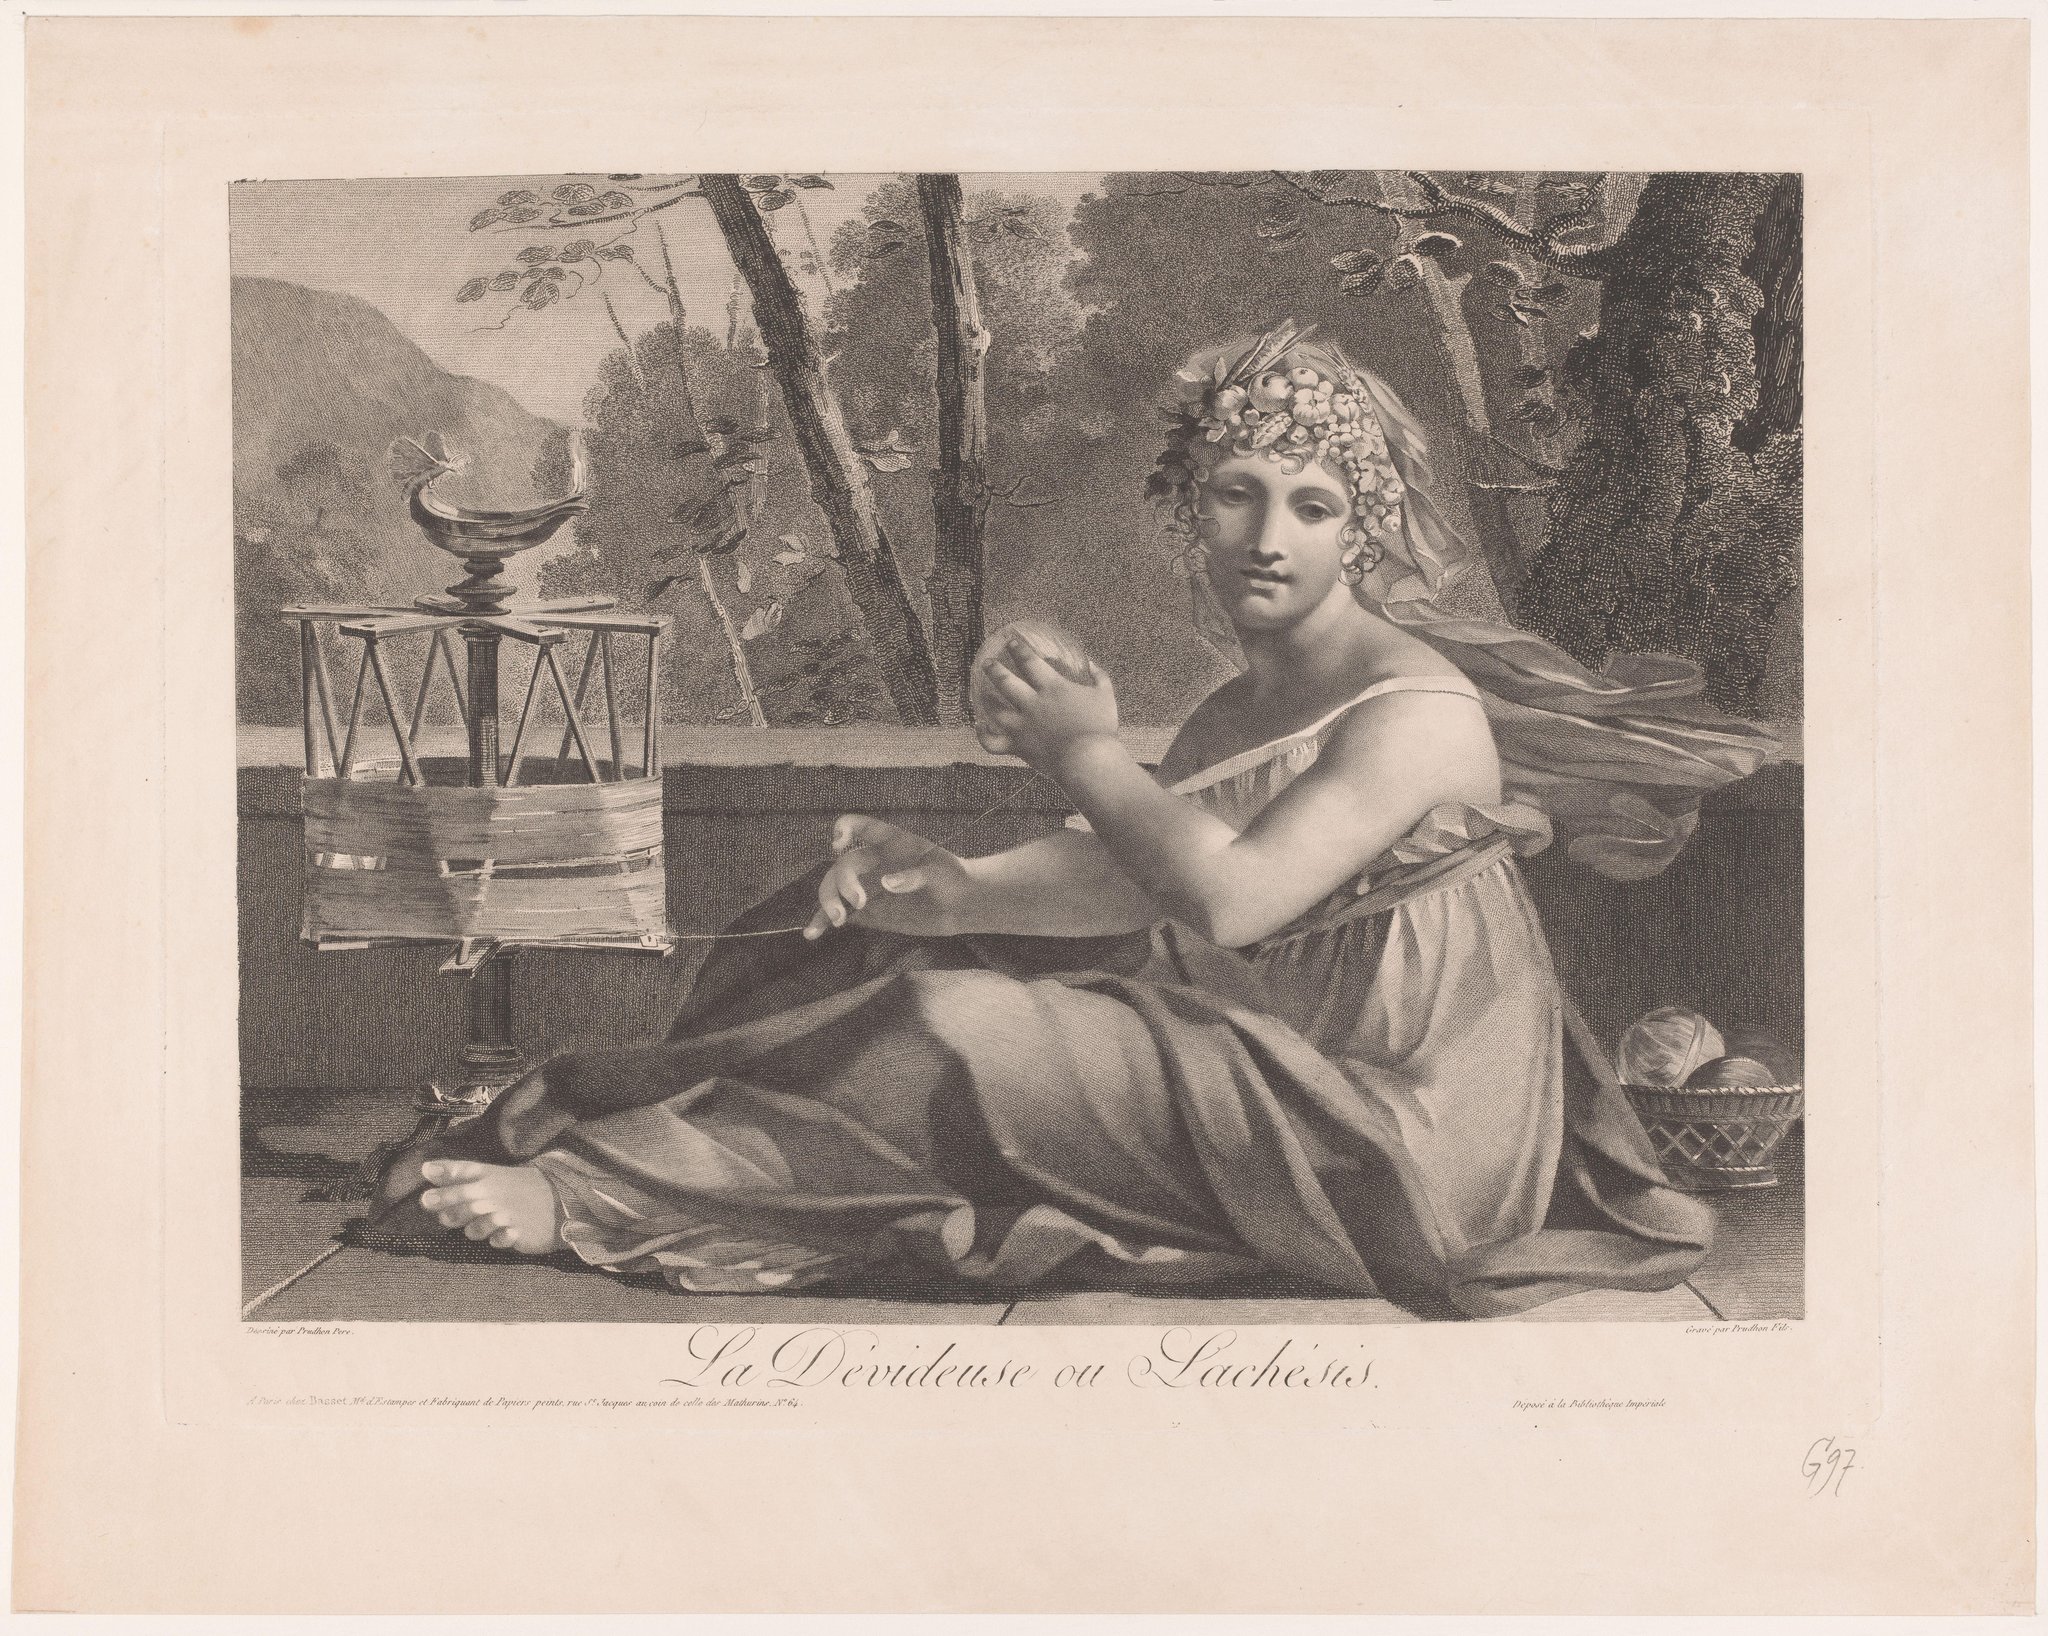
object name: print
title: La Dévideuse ou Lachésis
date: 1788-1819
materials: paper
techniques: engraving, etching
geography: paris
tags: lachesis, usually with spindle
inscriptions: collector's mark: Lugt 2228, : ‘Déposé à la Bibliothèque Impériale’, collector's mark: Lugt 2760